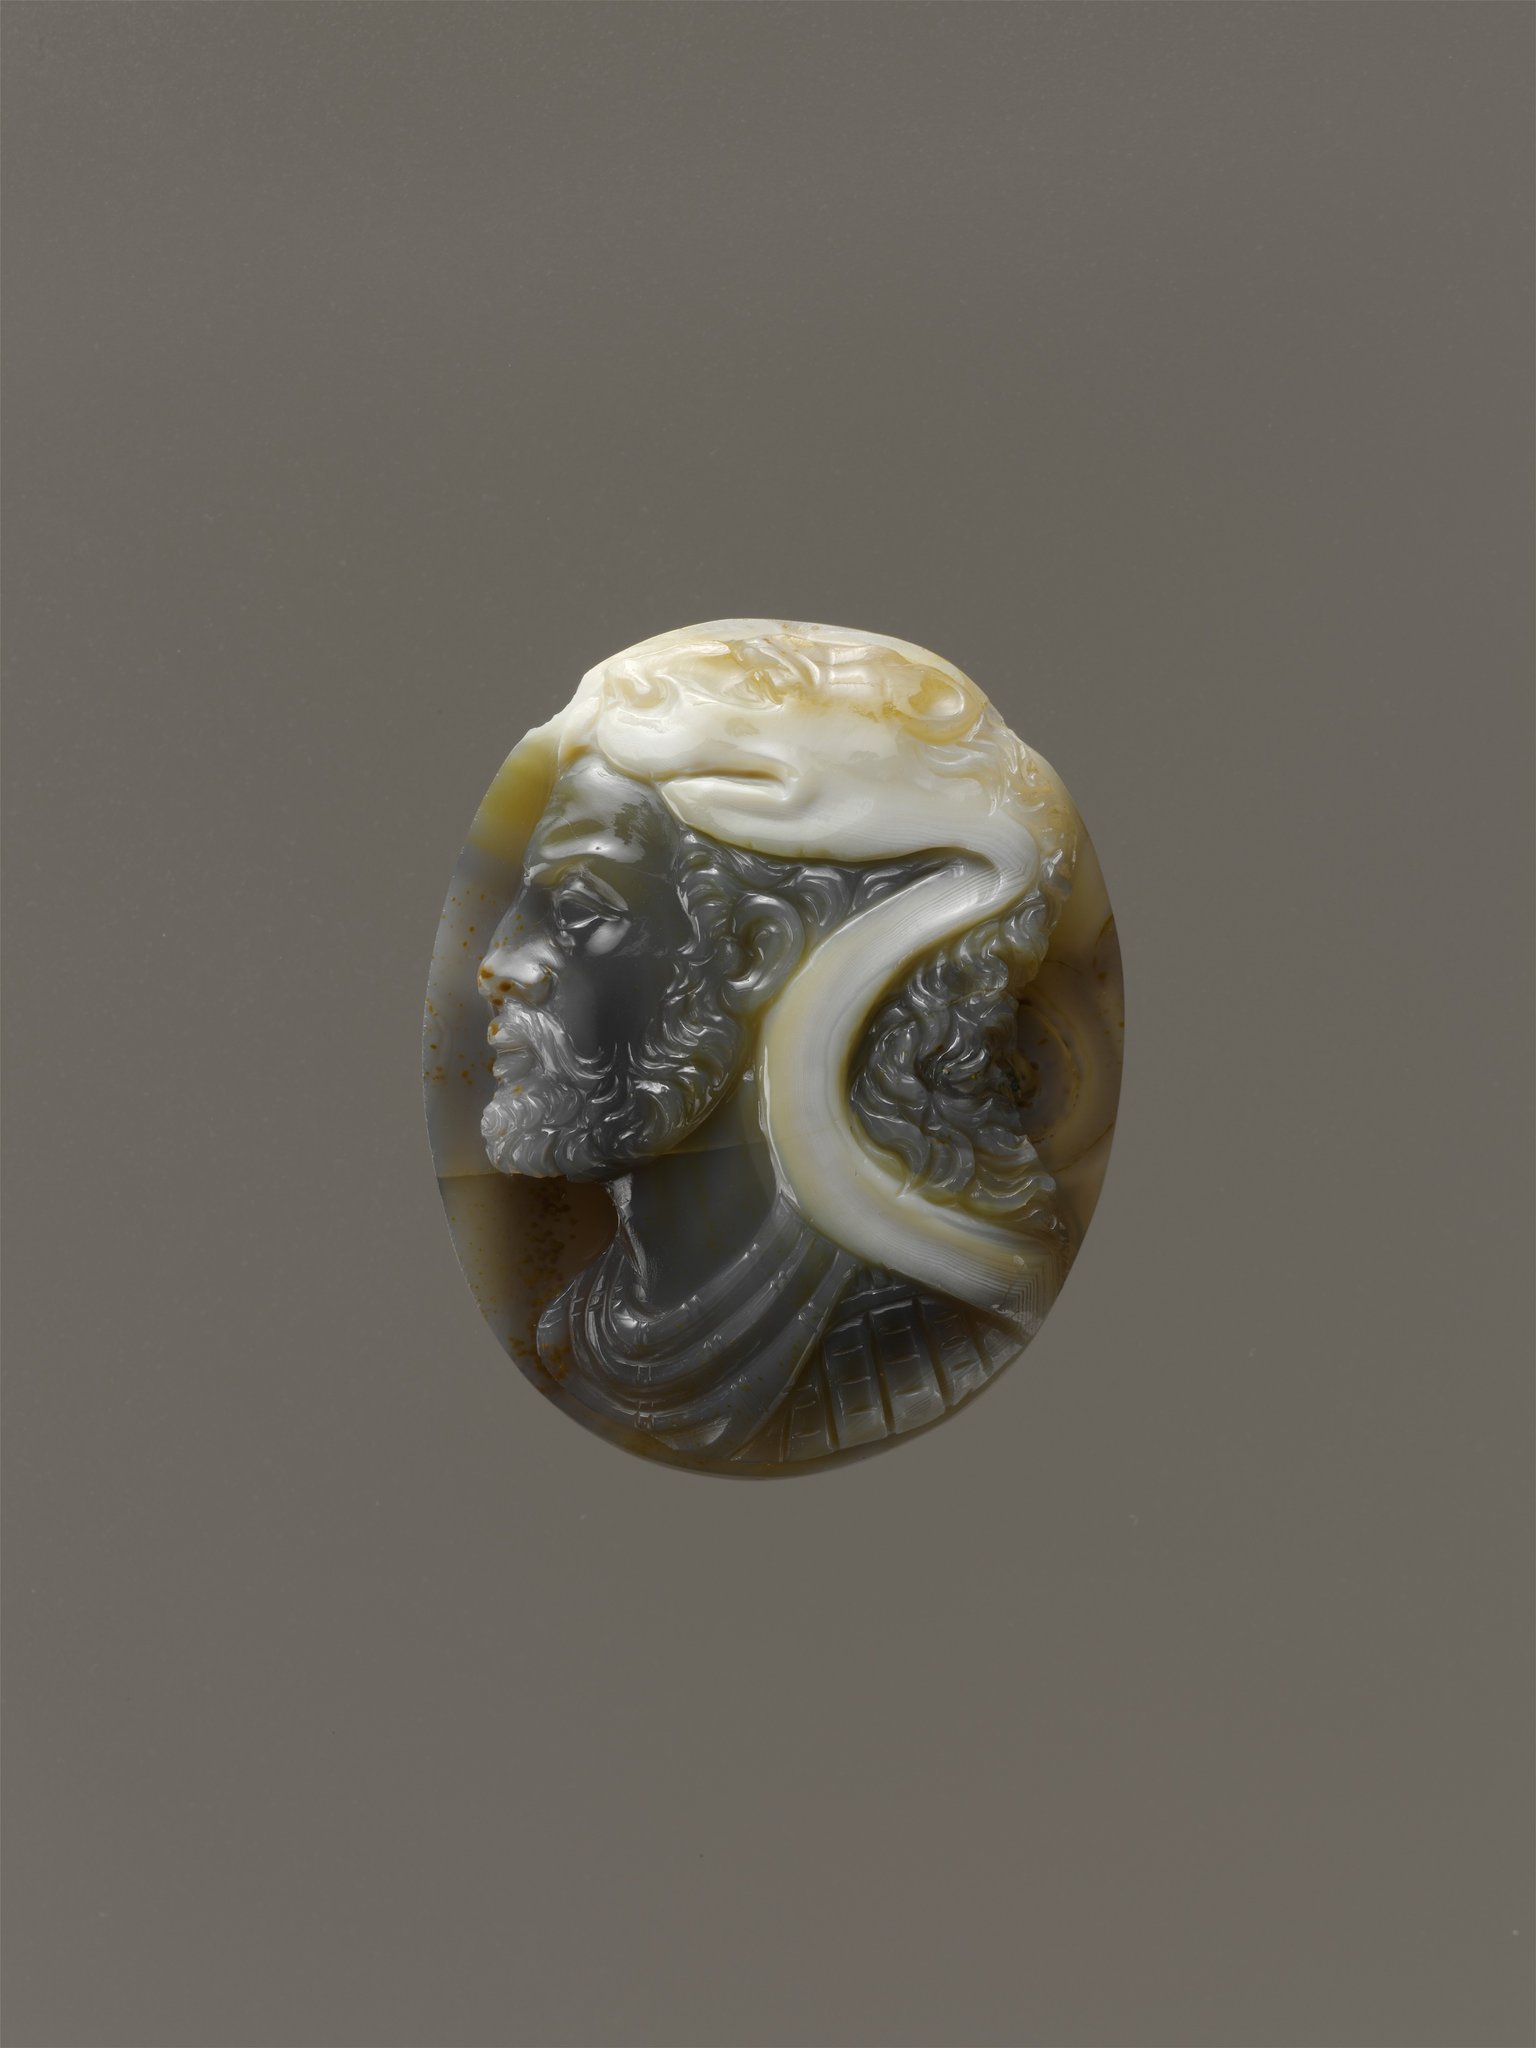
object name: cameo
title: Head of Hercules with the lion's skin and bust of Omphale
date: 1534-1566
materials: stone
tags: profiles,hercules